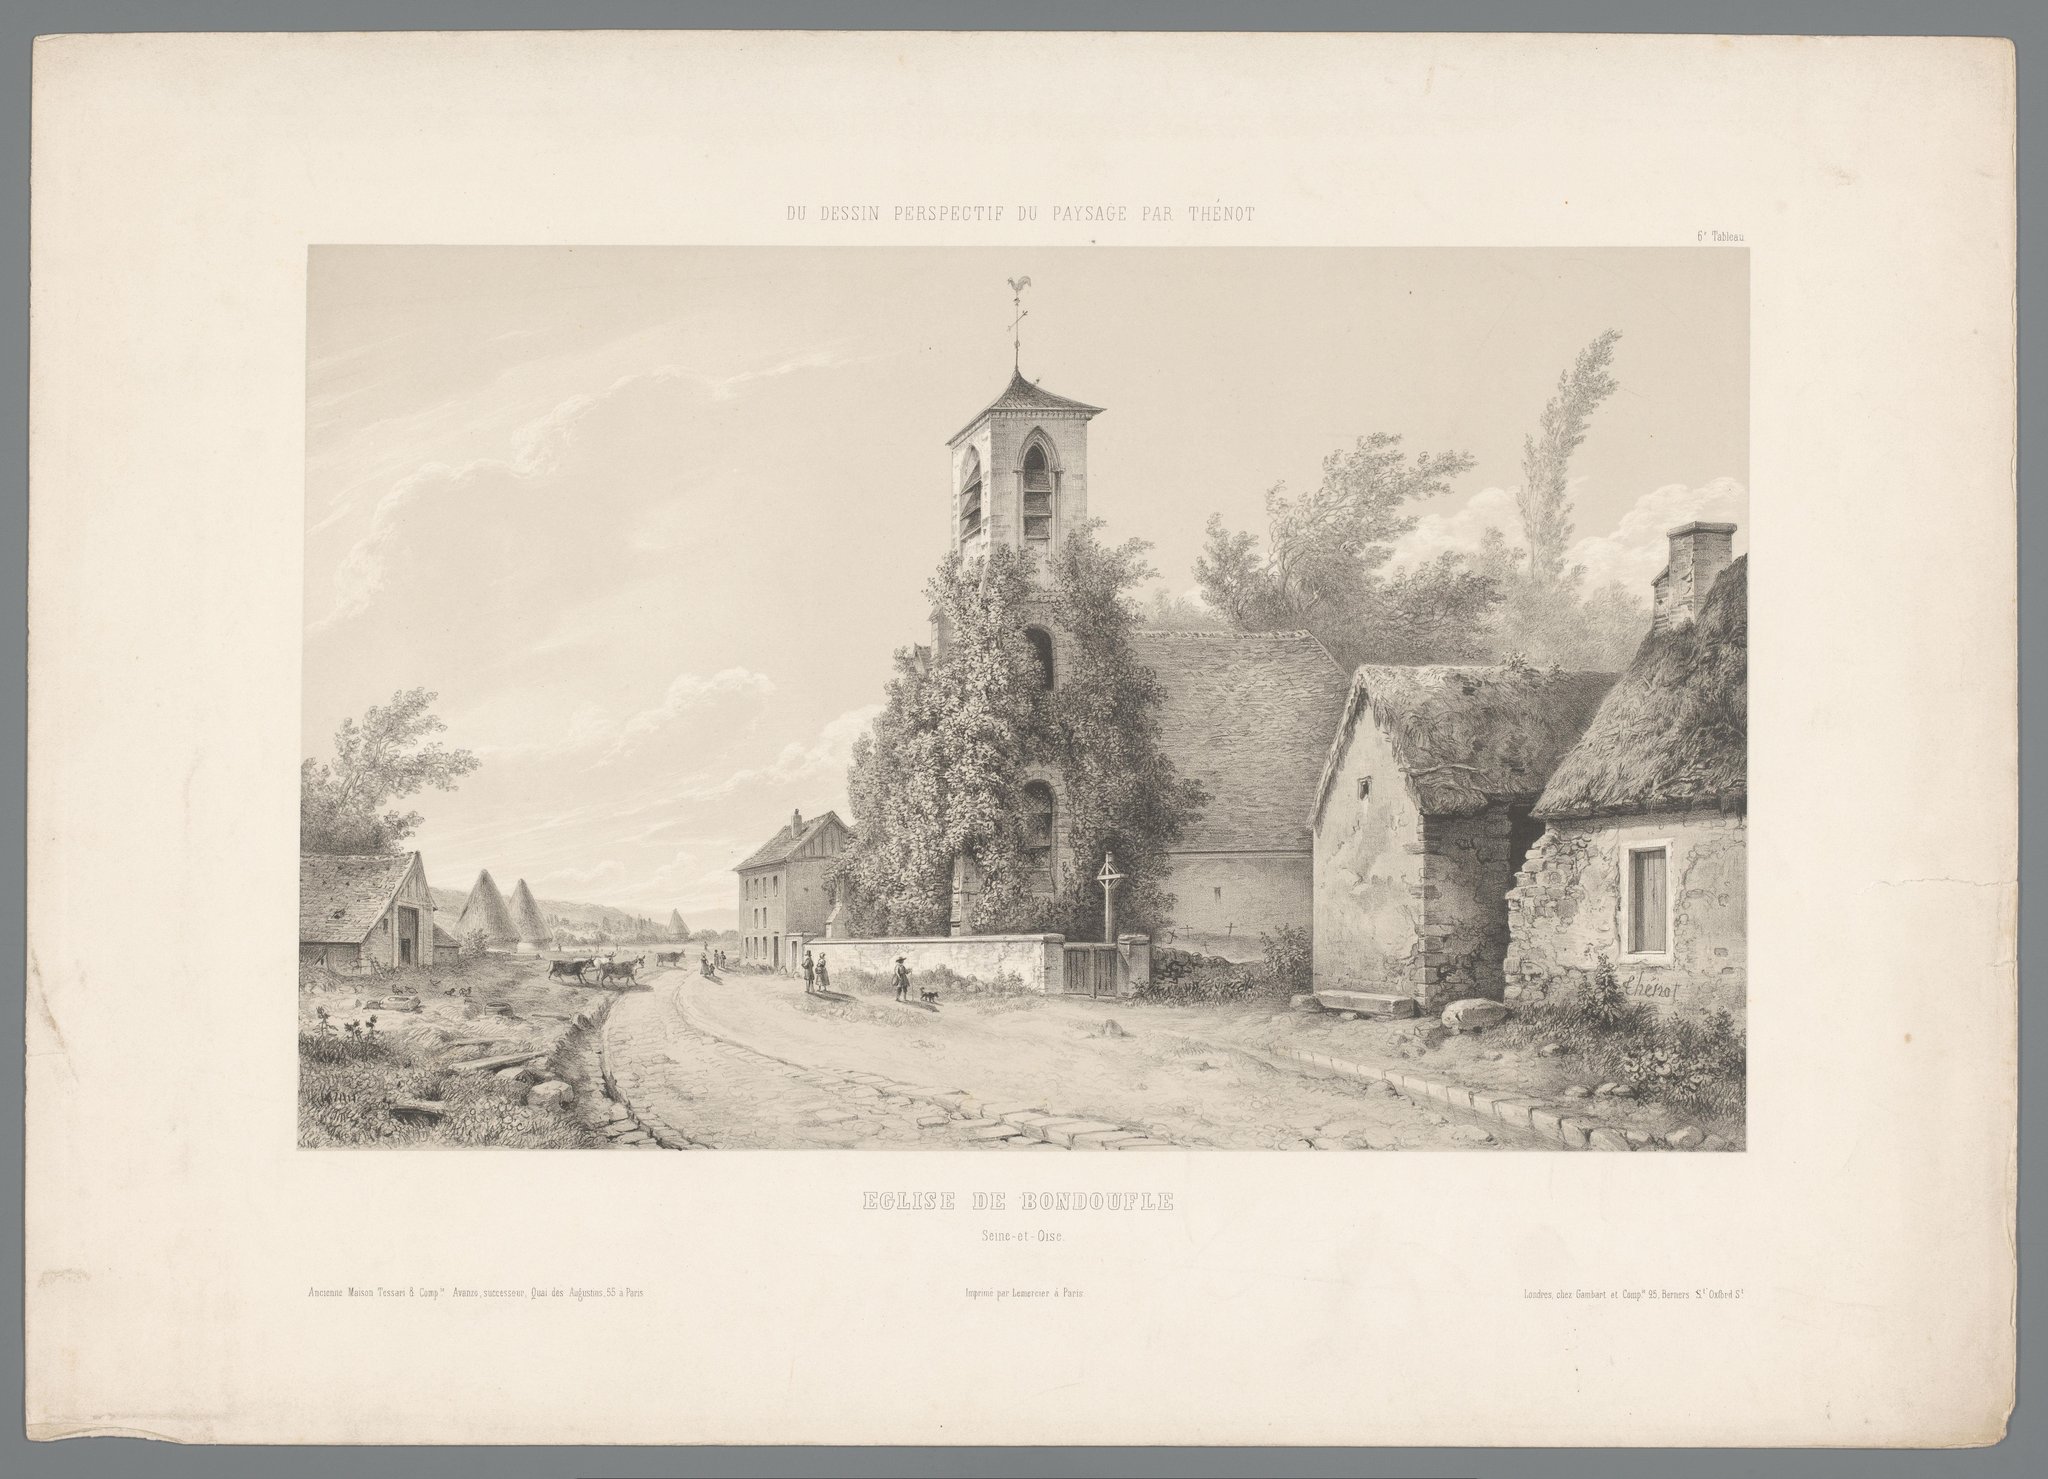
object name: print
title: Du dessin perspectif du paysage par Thénot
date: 1840-1870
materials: paper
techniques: tone lithography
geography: london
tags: village, building of church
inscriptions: collector's mark: Lugt 2228